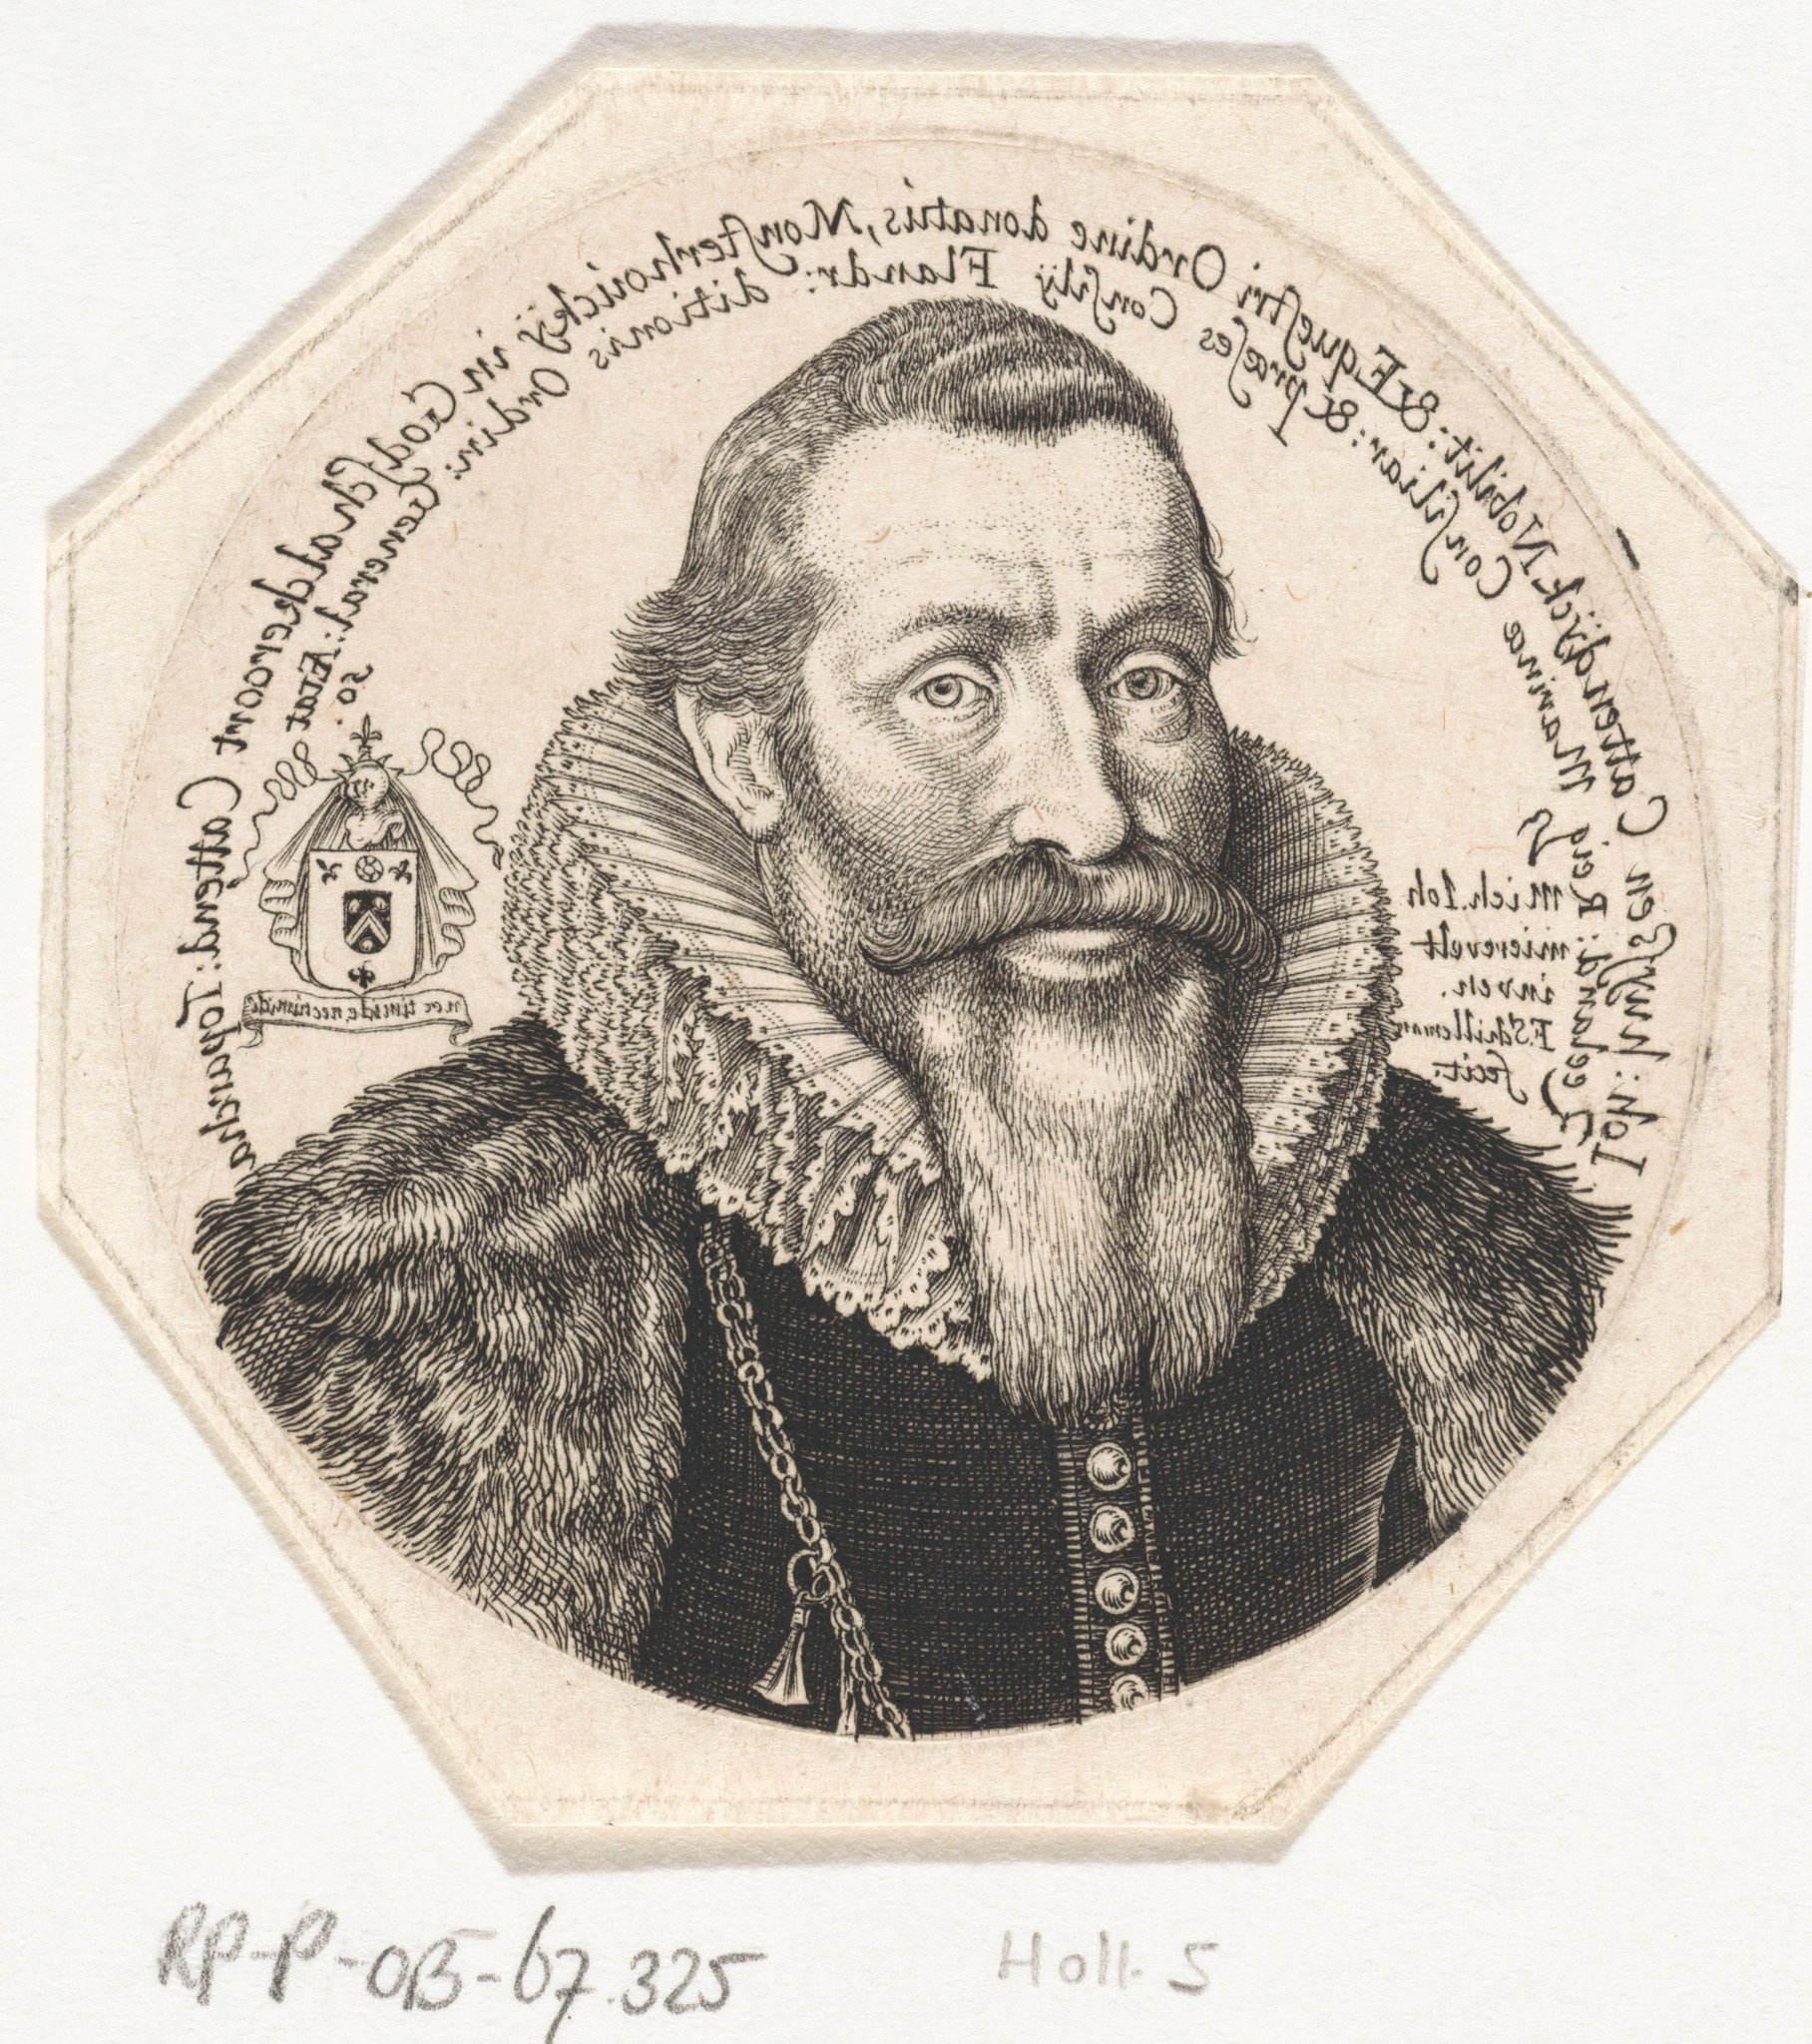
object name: print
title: Portret van Johan Huyssen van Kattendijke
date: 1585-1630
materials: paper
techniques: engraving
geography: middelburg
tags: johan huyssen van kattendijke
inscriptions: collector's mark: Lugt 2228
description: Het Huis met de Hoofden aan de Keizersgracht te Amsterdam.